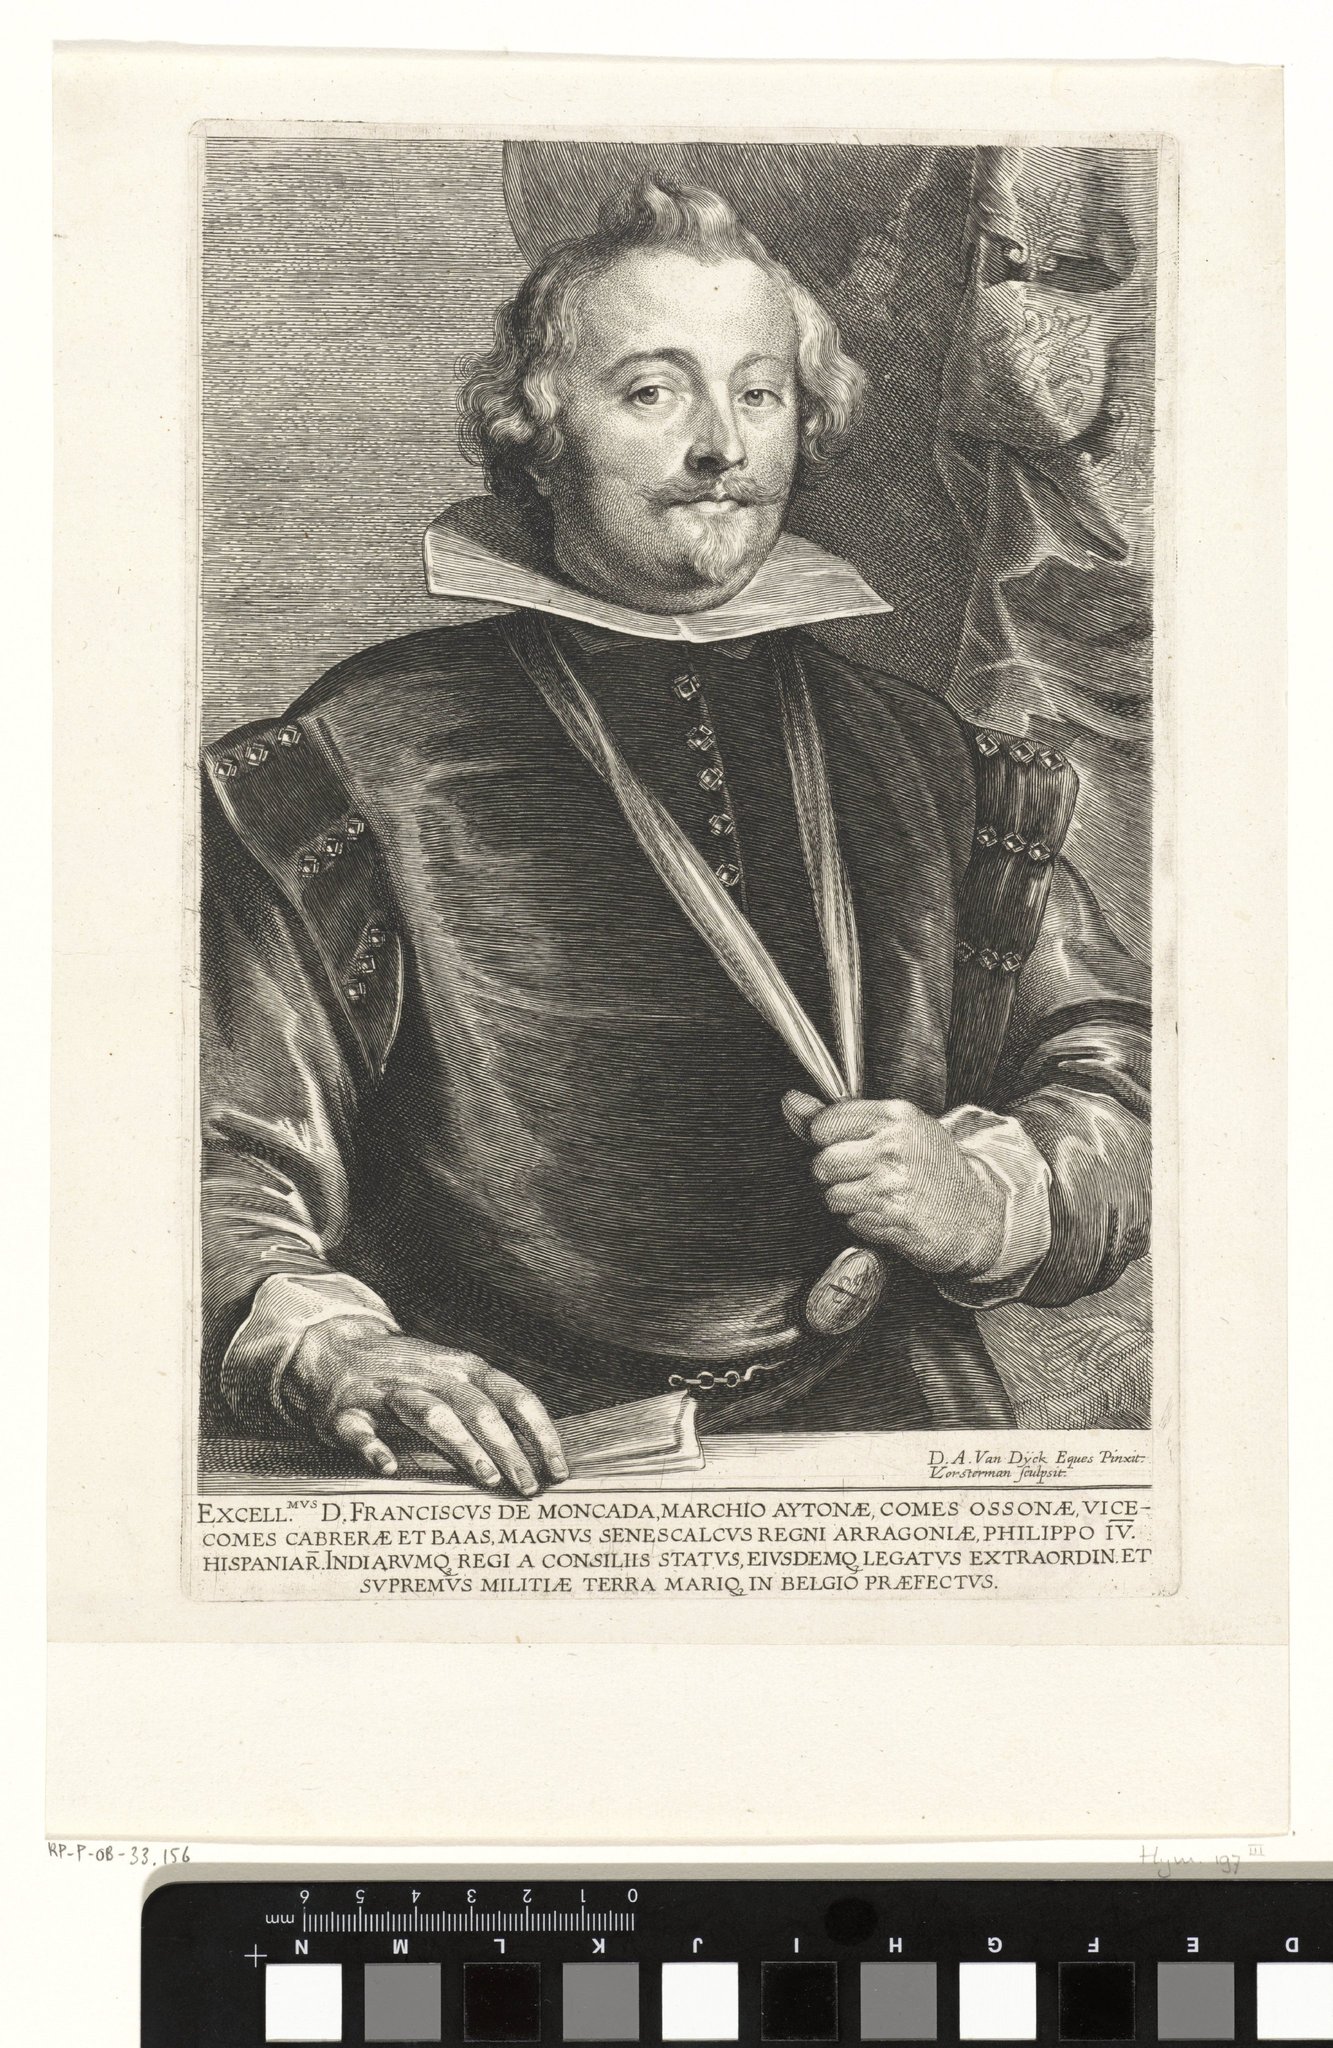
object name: print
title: Portret van Francisco de Moncada, markies van Aytona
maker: lucas vorsterman (i)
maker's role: print maker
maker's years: 1595-1675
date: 1630-1646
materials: paper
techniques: engraving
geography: antwerp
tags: brussels, francisco de moncada (markies van aytona)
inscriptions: collector's mark: Lugt 240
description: Prent gebruikt voor: Icones principum, virorum doctorum, pictorum, chalcographorum, statuariorum nec non amatorum pictoriae artis numero centum ab Ant. van Dyck ad vivum expressae ejusque sumptibus aeri incisae. Antwerpen: Gillis Hendricx, [1645-1646].